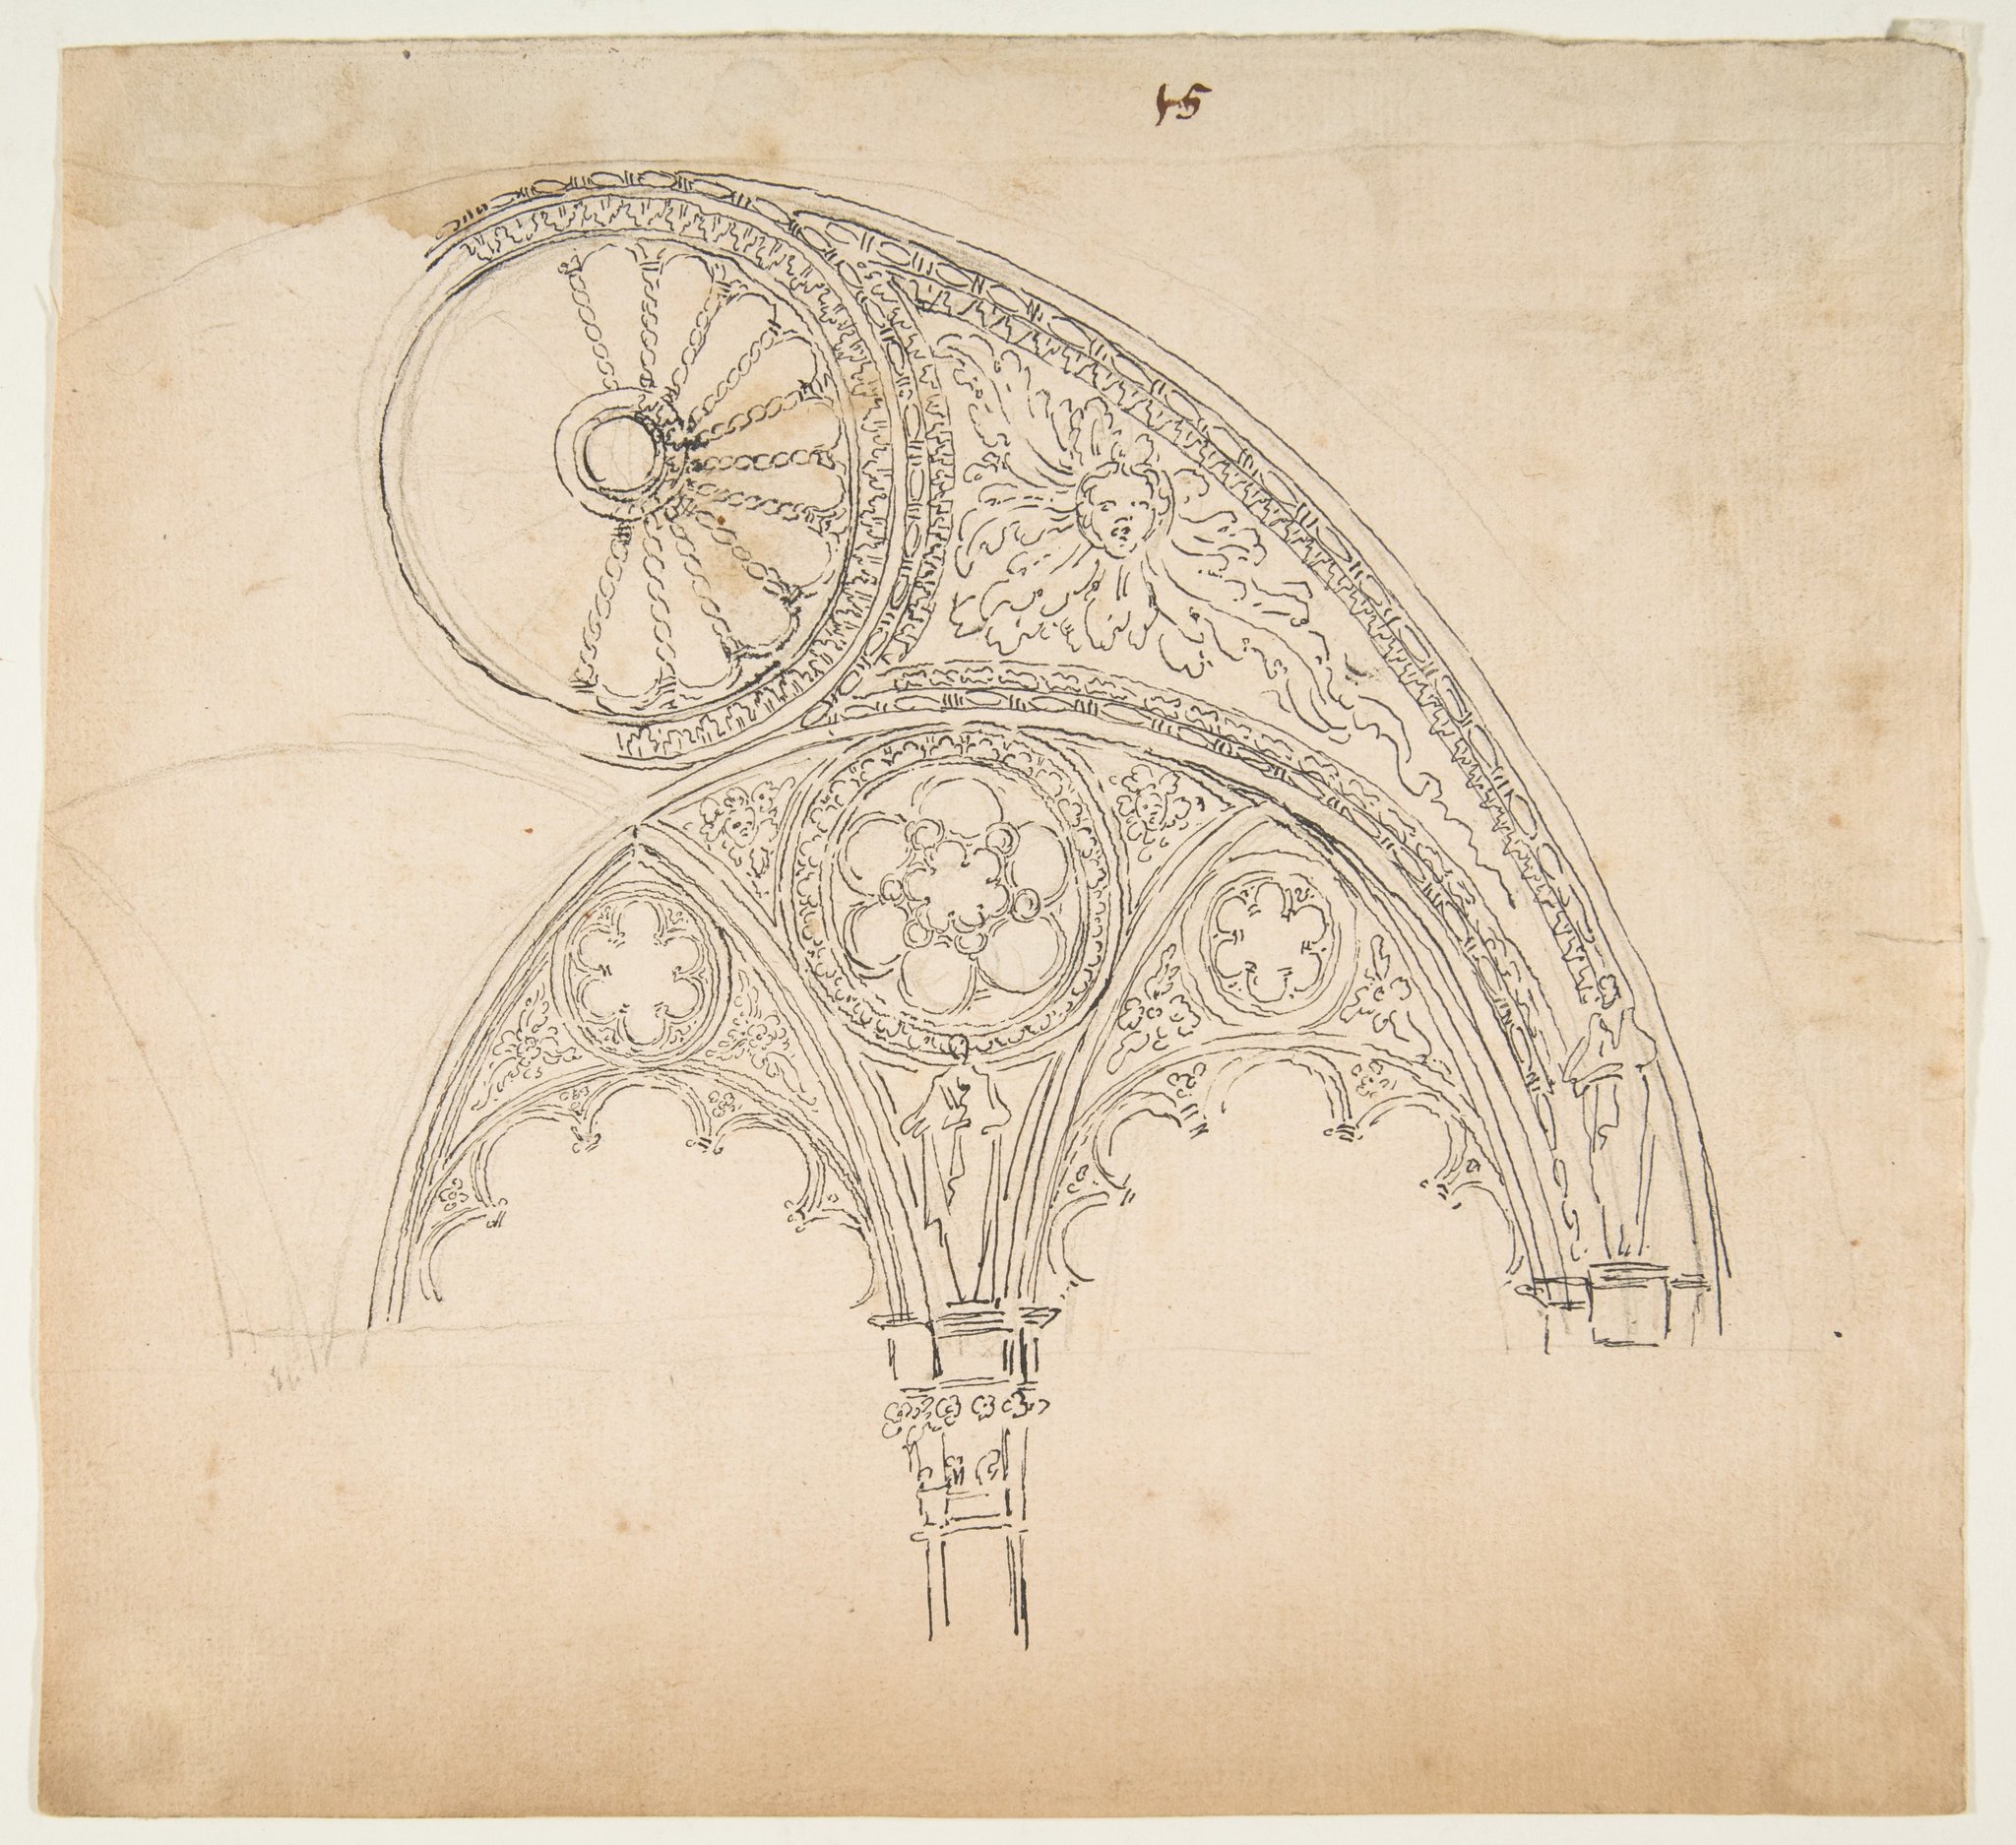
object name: drawing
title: Drawing After an Architectural Fragment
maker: anonymous, french, 19th century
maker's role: artist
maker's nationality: french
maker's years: 1800-1900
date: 1801-1900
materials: graphite, ink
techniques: pen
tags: architecture